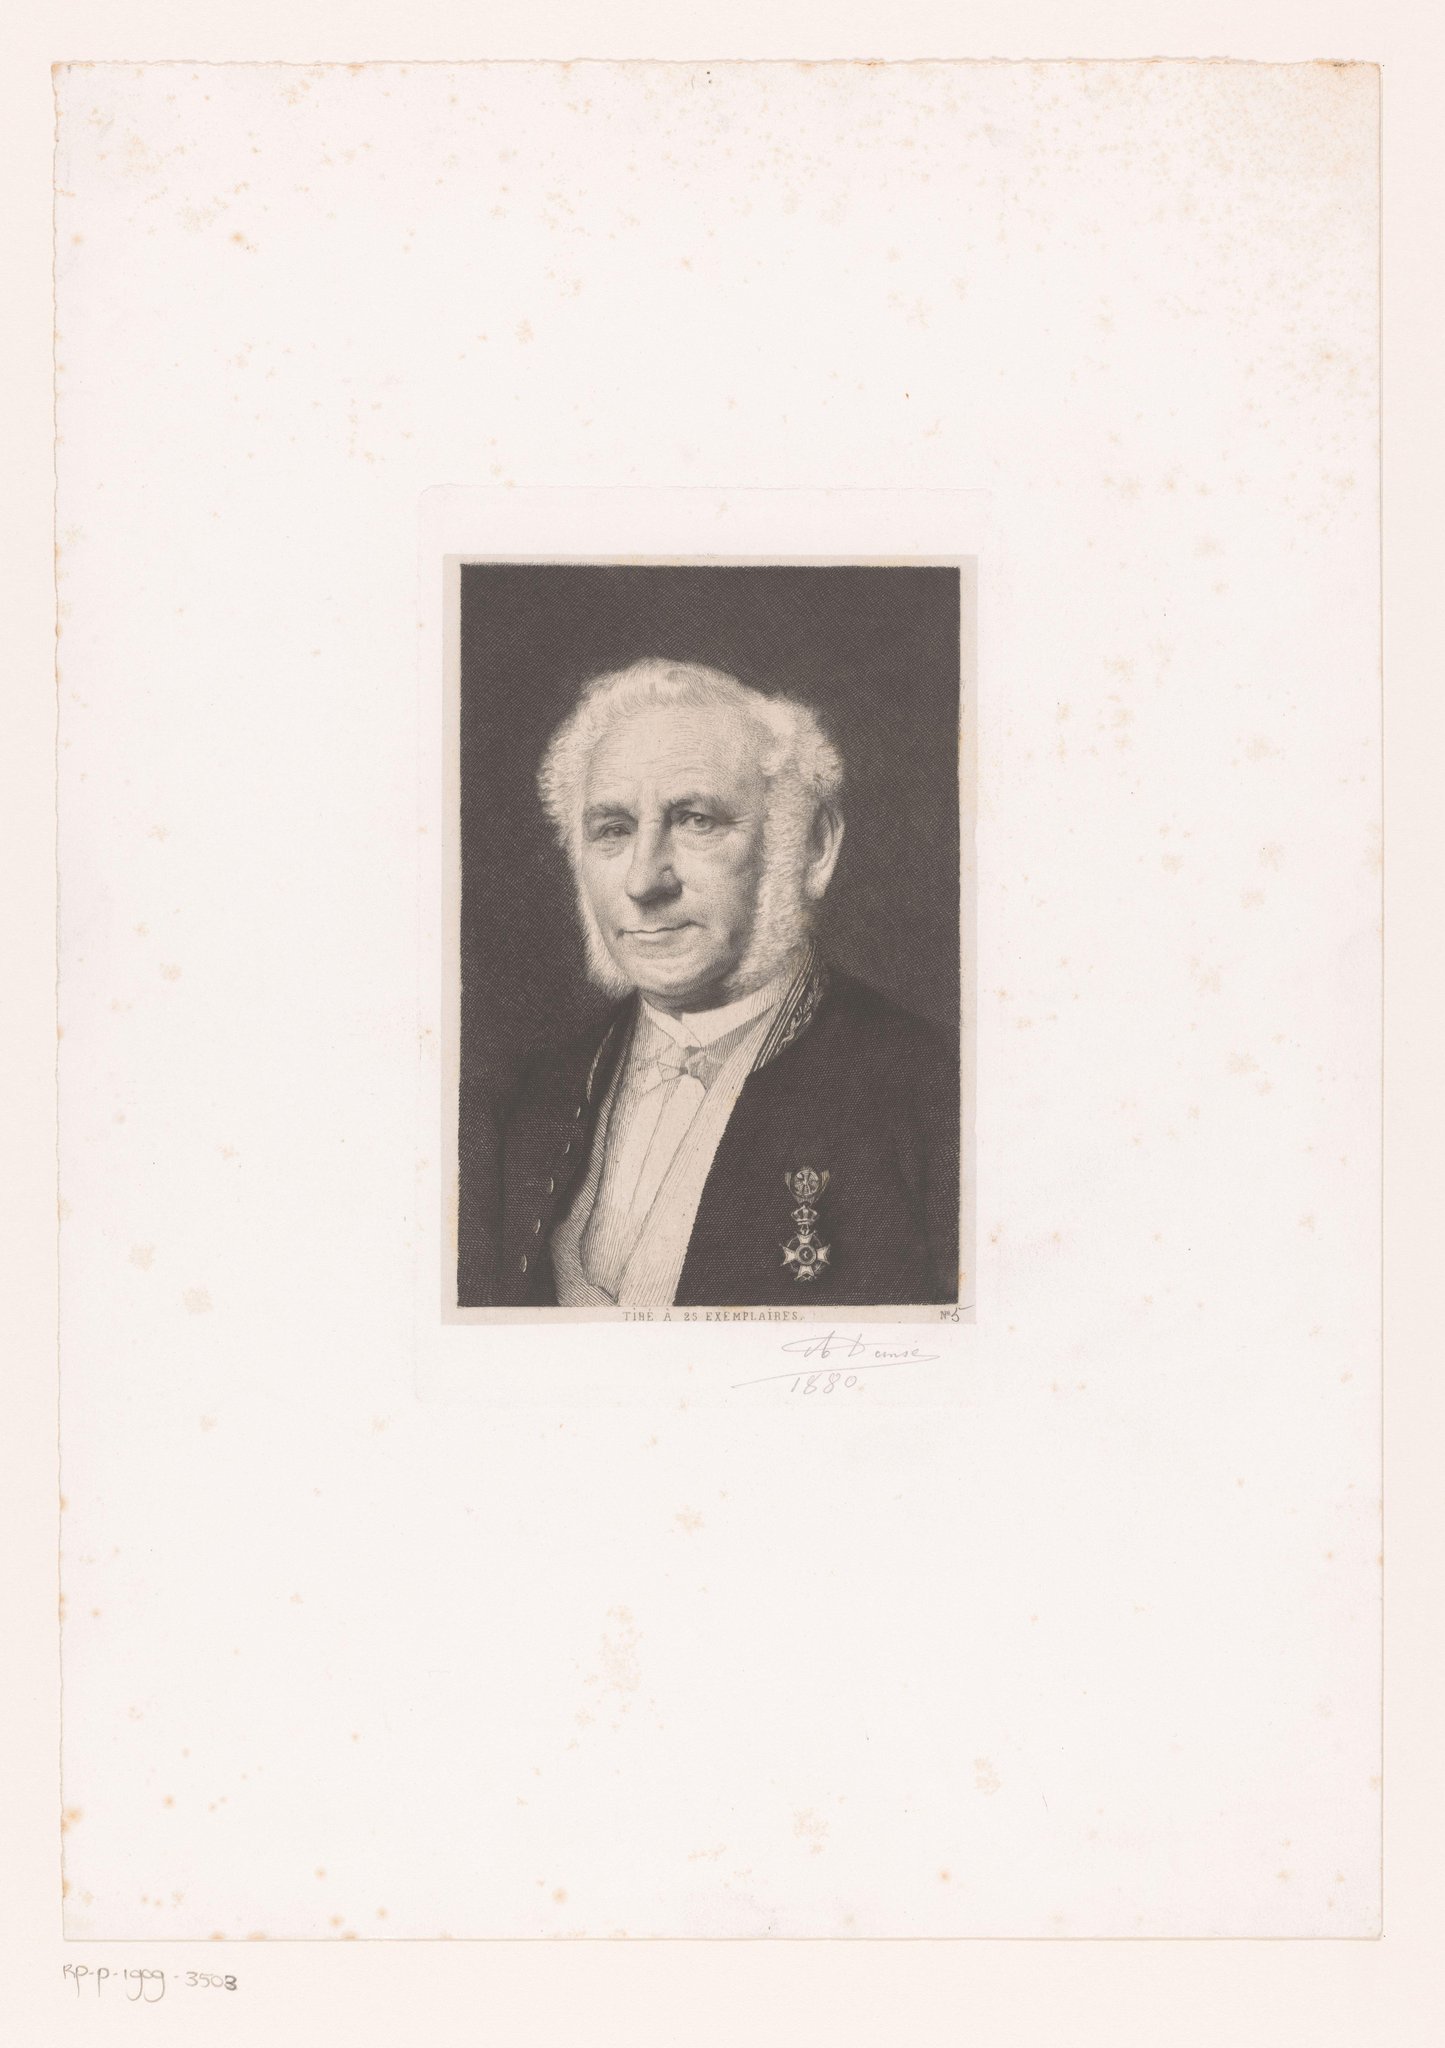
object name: print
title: Portret van François Dolez, burgemeester van Mons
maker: auguste danse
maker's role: print maker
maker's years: 1829-1929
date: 1880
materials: paper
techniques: etching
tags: politician, historical person (...) - historical person (...) portrayed alone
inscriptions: inscription: ‘Tiré à 25 exemplaries. No. 5.’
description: Dezelfde prentmaker heeft meerdere portretten van Dolez geëtst, die sterk op elkaar lijken. Zie RP-P-1909-3497 t/m RP-P-1909-3503.